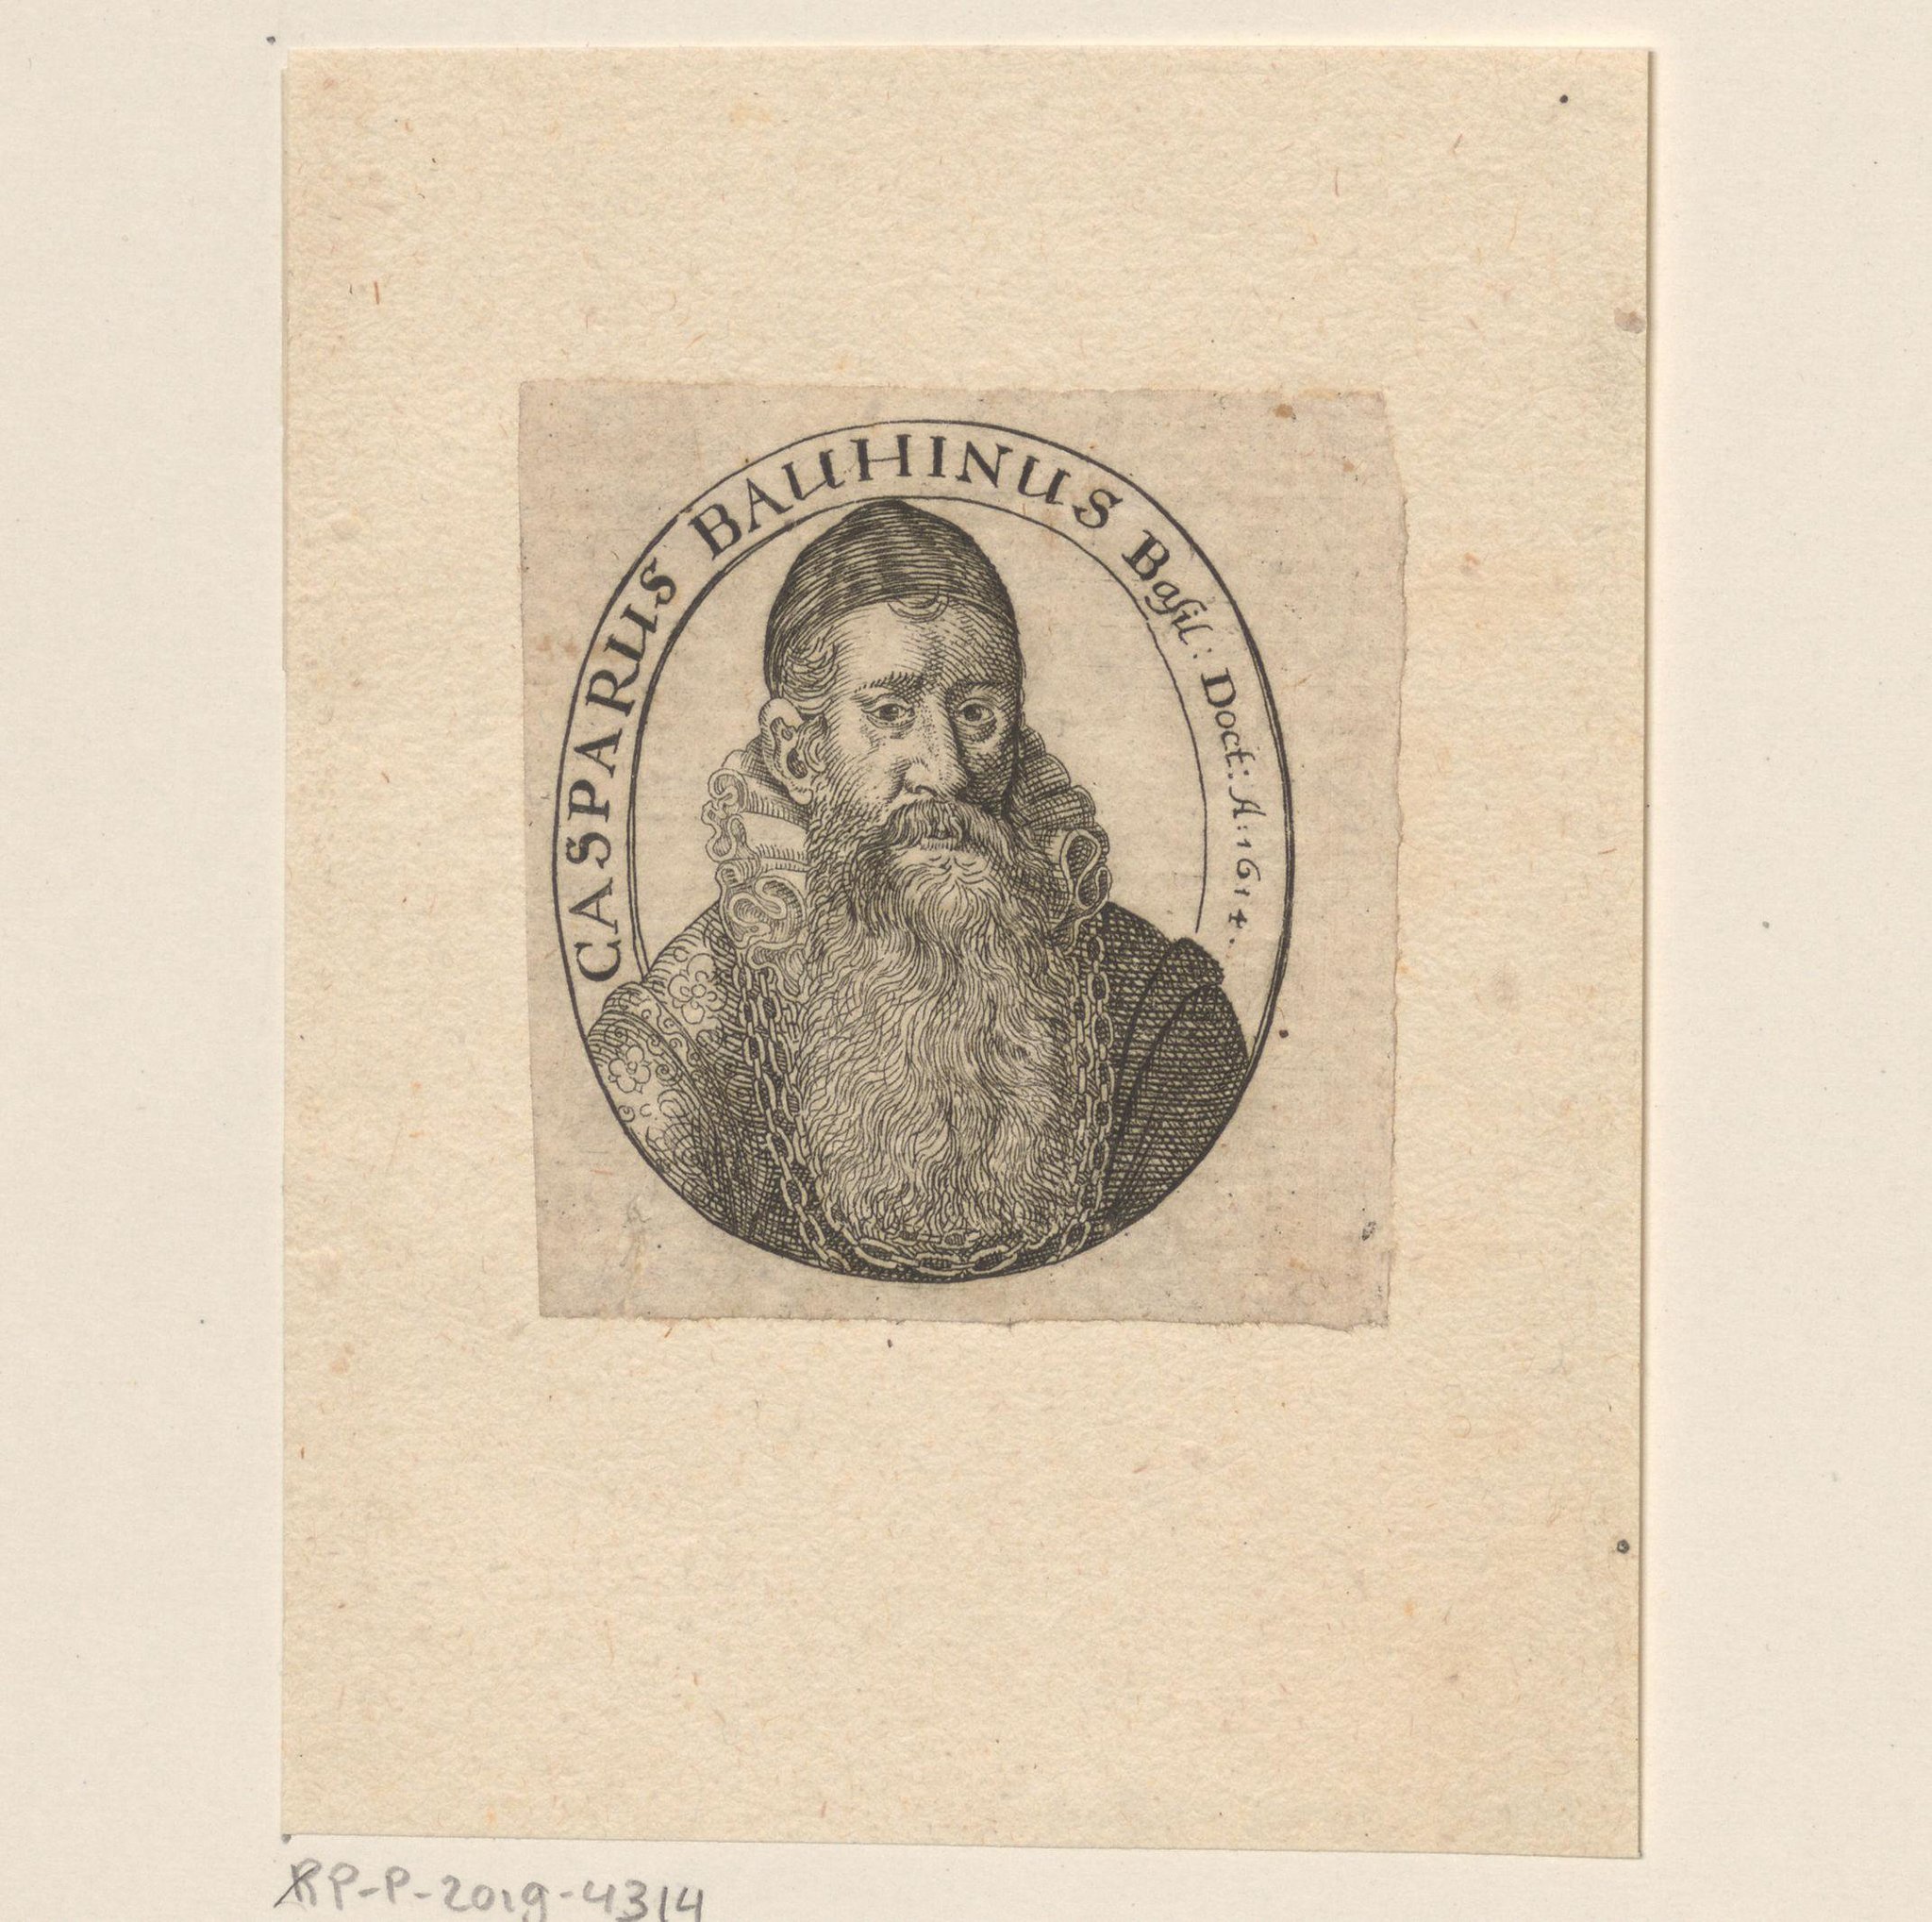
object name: print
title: Portret van Caspar Bauhin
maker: Anonymous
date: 1614-1649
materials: paper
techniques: engraving, etching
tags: historical persons, botany